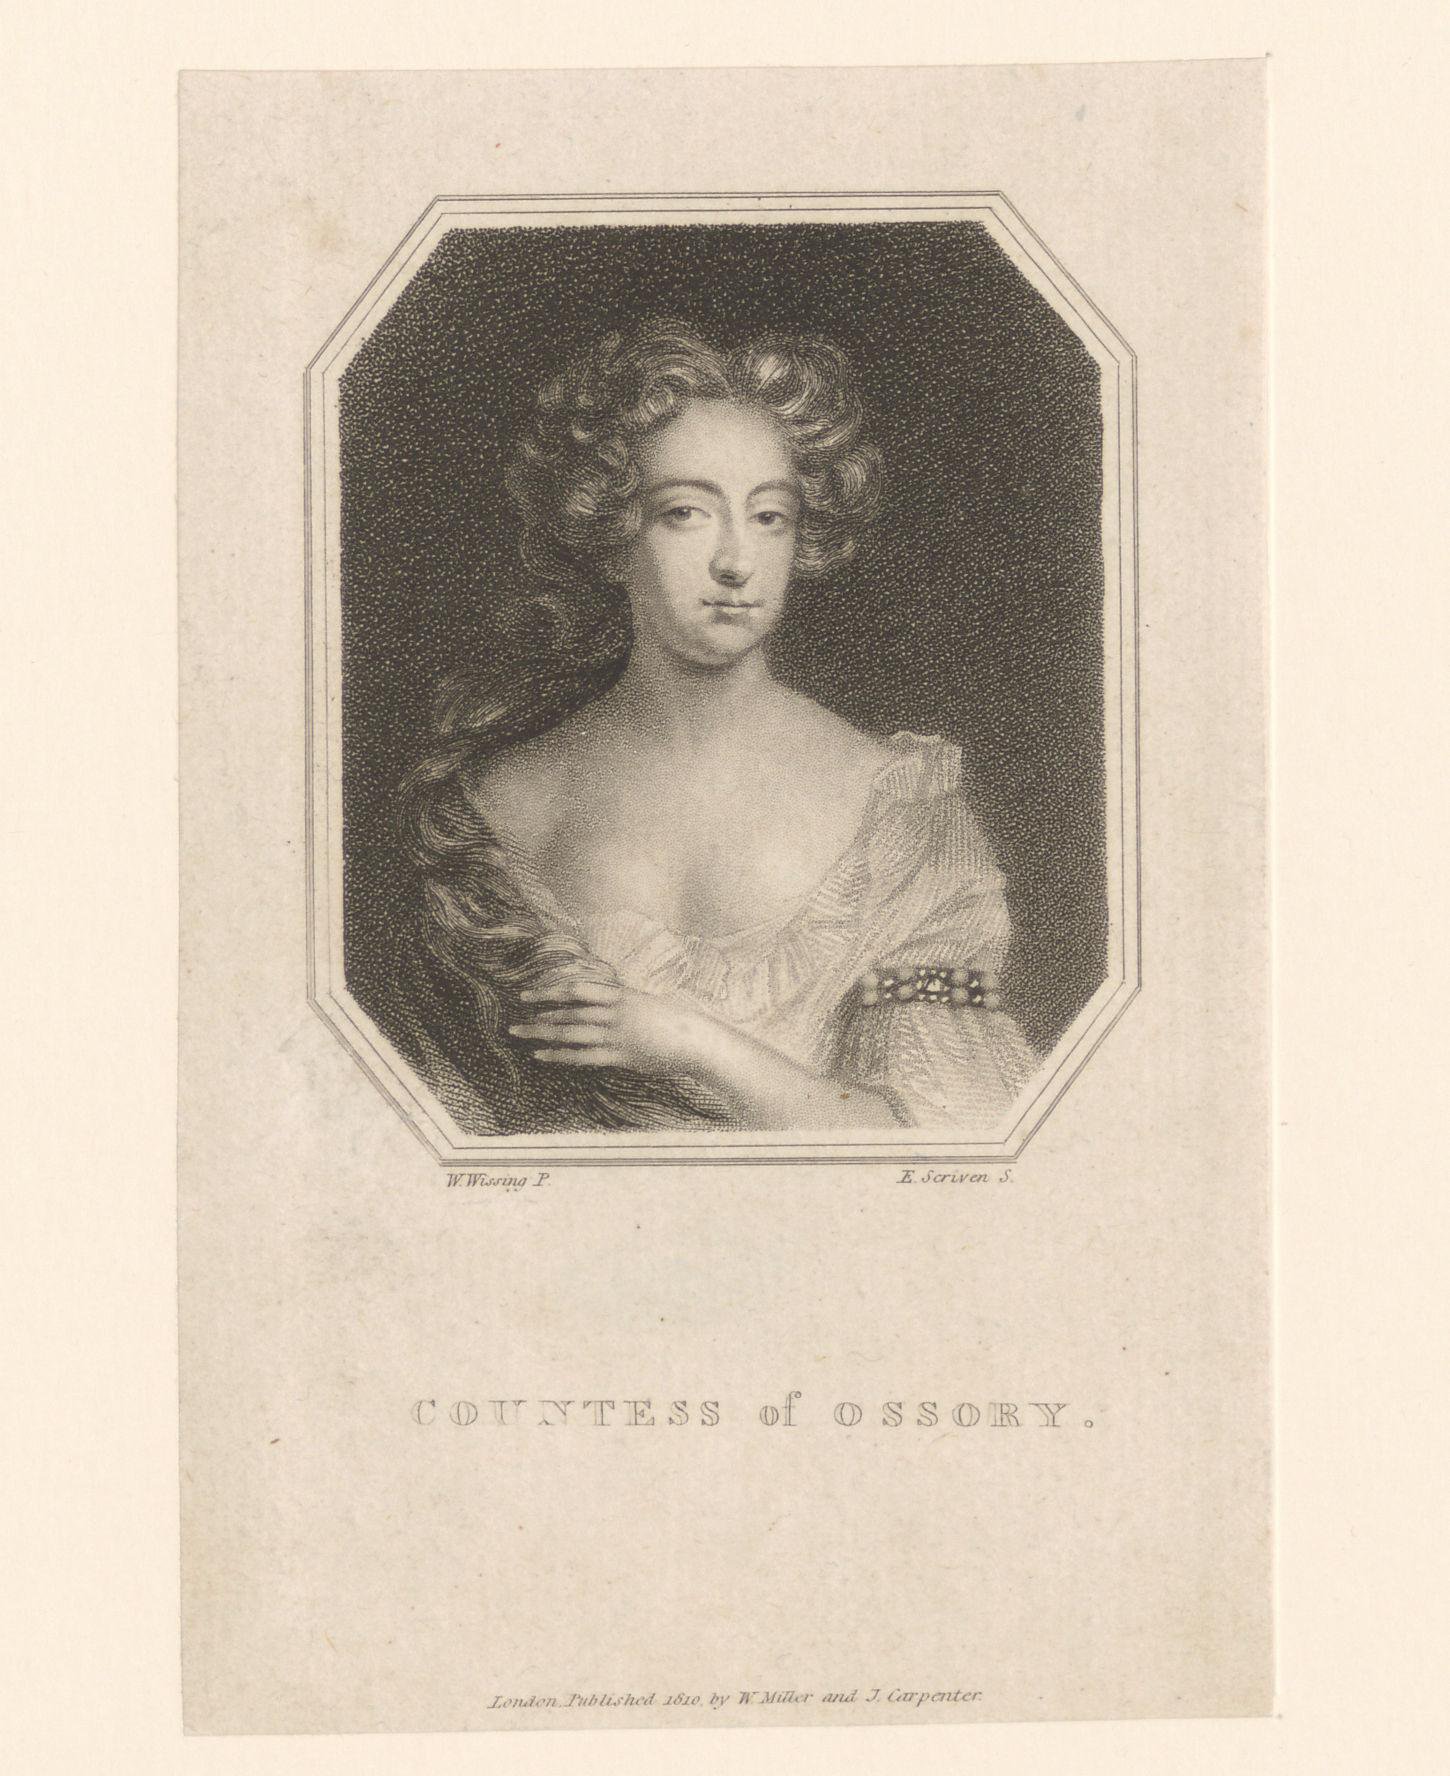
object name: print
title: Portret van Emilia Butler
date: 1810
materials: paper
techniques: etching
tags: the hague, london, historical persons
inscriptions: collector's mark: Lugt 2228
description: Prent gebruikt in: Hamilton, Anthony. Memoirs of Count Grammont. Londen: Carpenter & Miller, 1811.